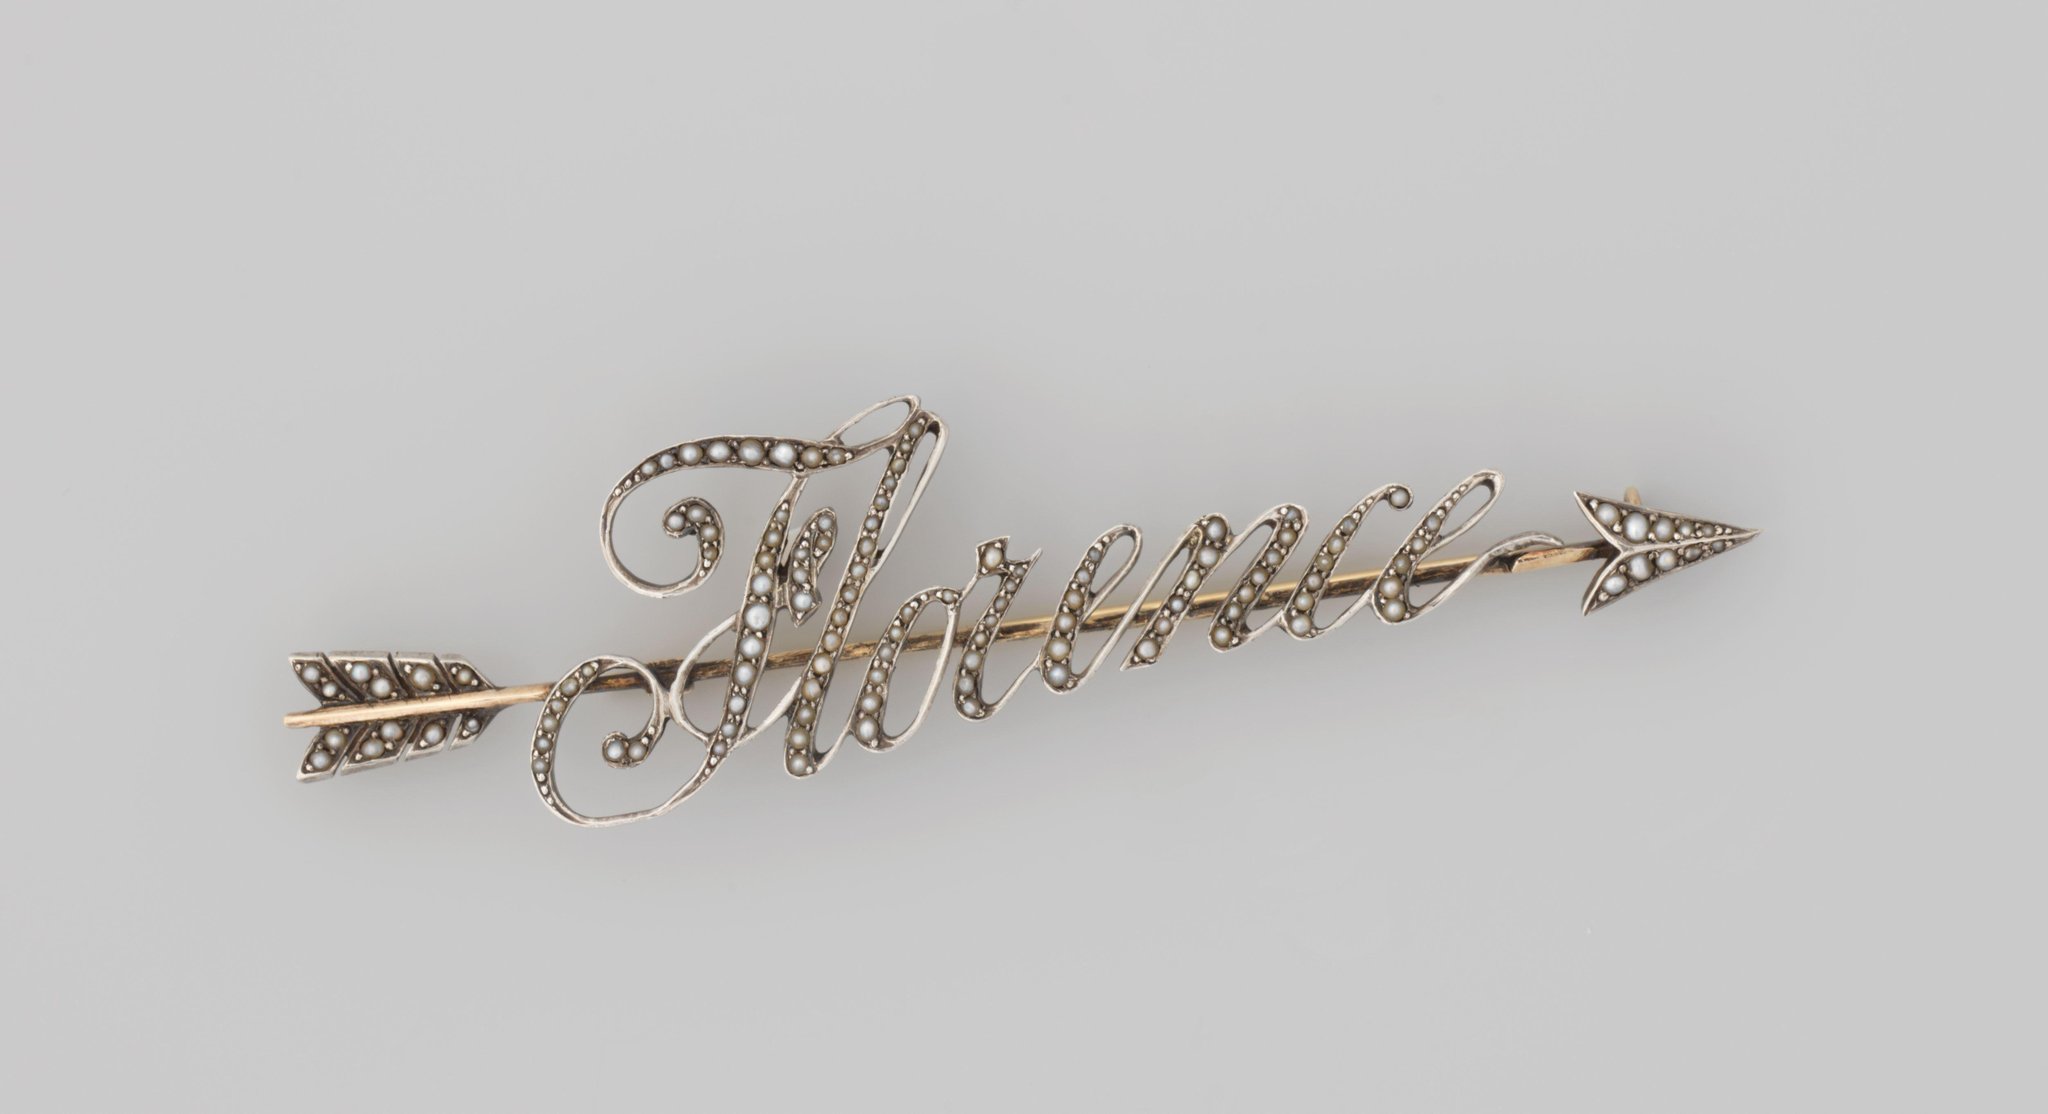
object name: brooch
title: Broche 'Florence'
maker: Anonymous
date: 1870-1890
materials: gold, pearl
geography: england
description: Broche van goud met cursieve letters "Florence" op een pijl, geheel bezet met kleine zaadparels, voorzien van een brochering met een haaksluiting. Geen verantwoordelijkheidstekens.